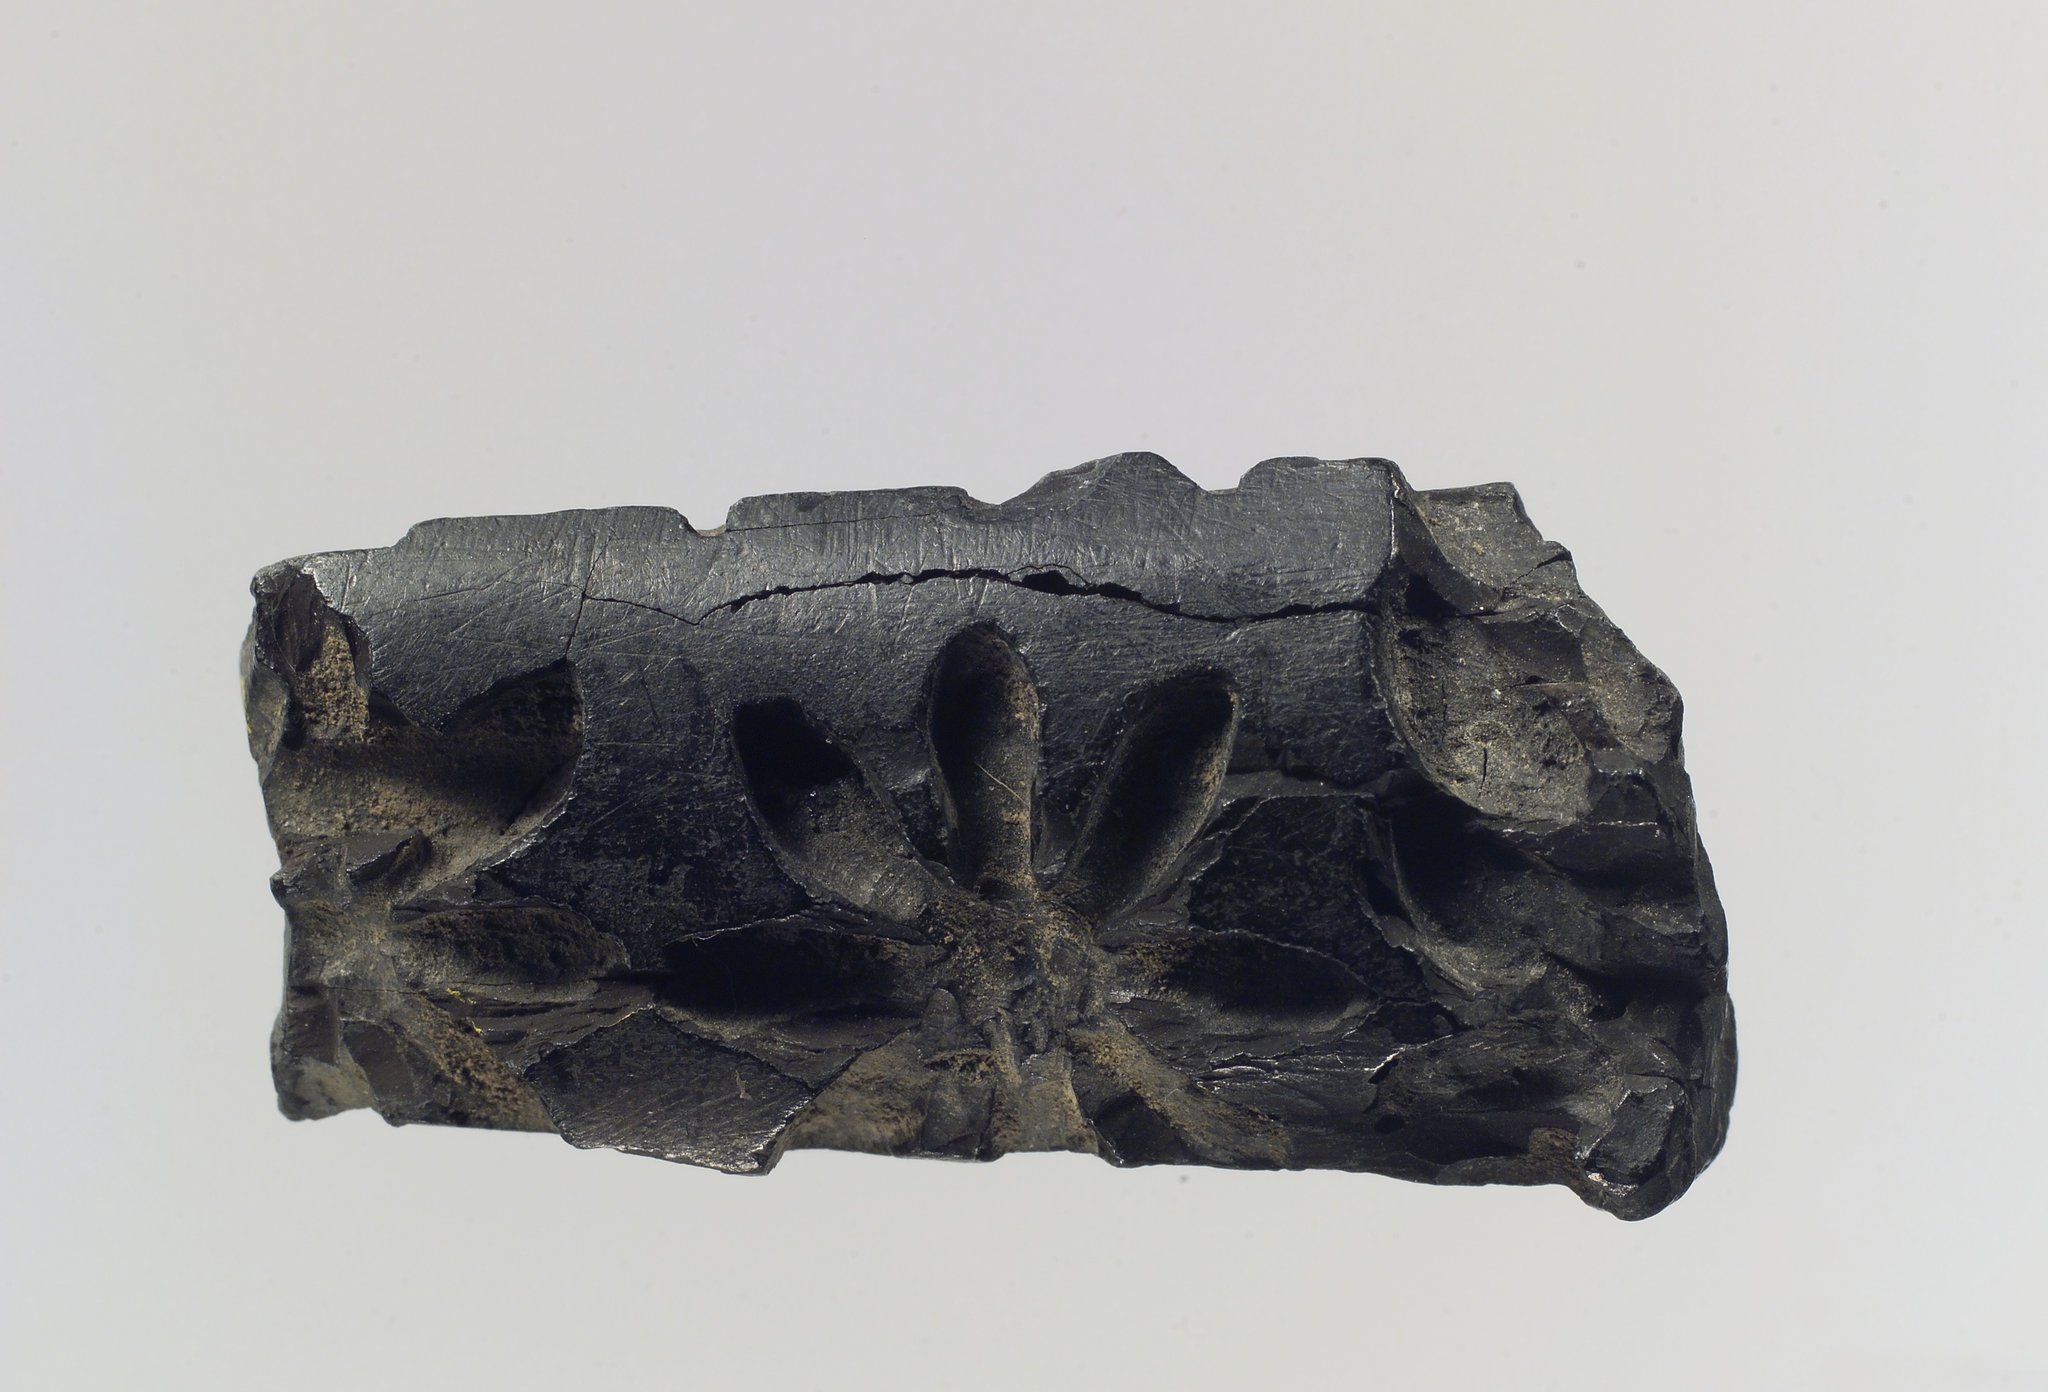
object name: relief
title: Ivory fragment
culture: iranian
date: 900-801 BCE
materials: ivory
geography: iran